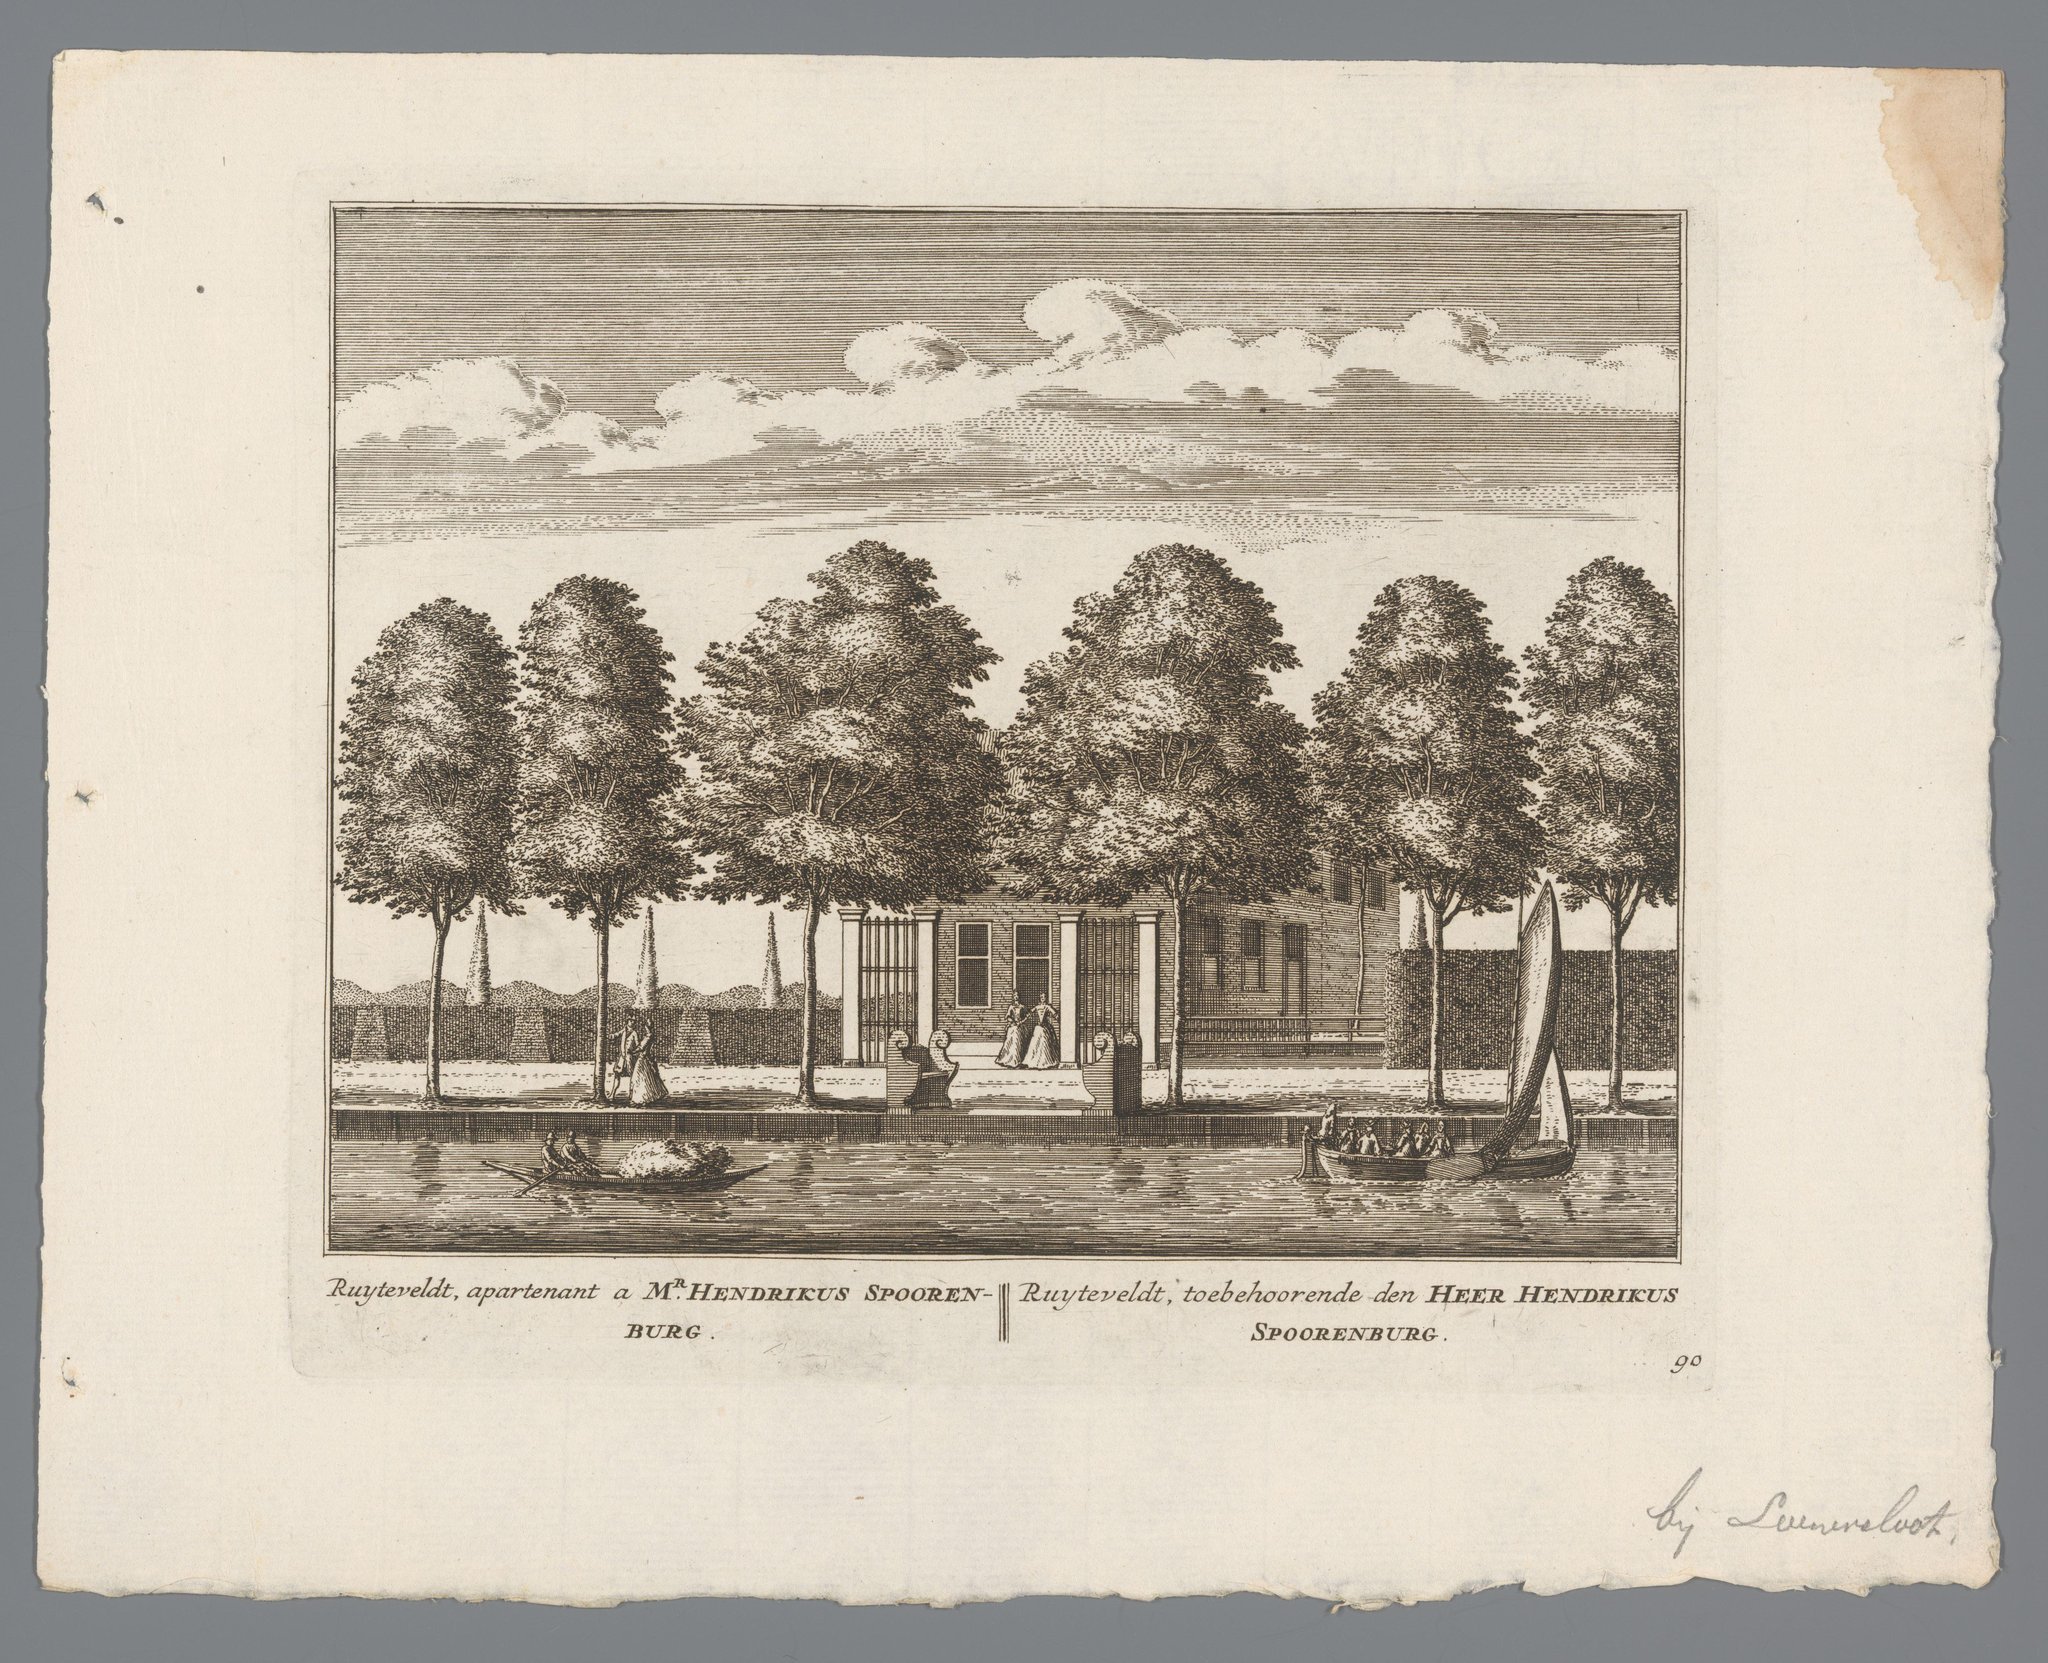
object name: book illustration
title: Gezicht op de buitenplaats Ruyteveldt, bij Loenersloot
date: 1730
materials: paper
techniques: etching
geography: amsterdam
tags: rural housing, e.g. country-house, villa, cottage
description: Prent uit: Rademaker, Abraham. Hollands Arcadia, of de vermaarde rivier den Amstel (...) / L'Arcadie Hollandoise (...). Amsterdam: Leonard Schenk, 1730.